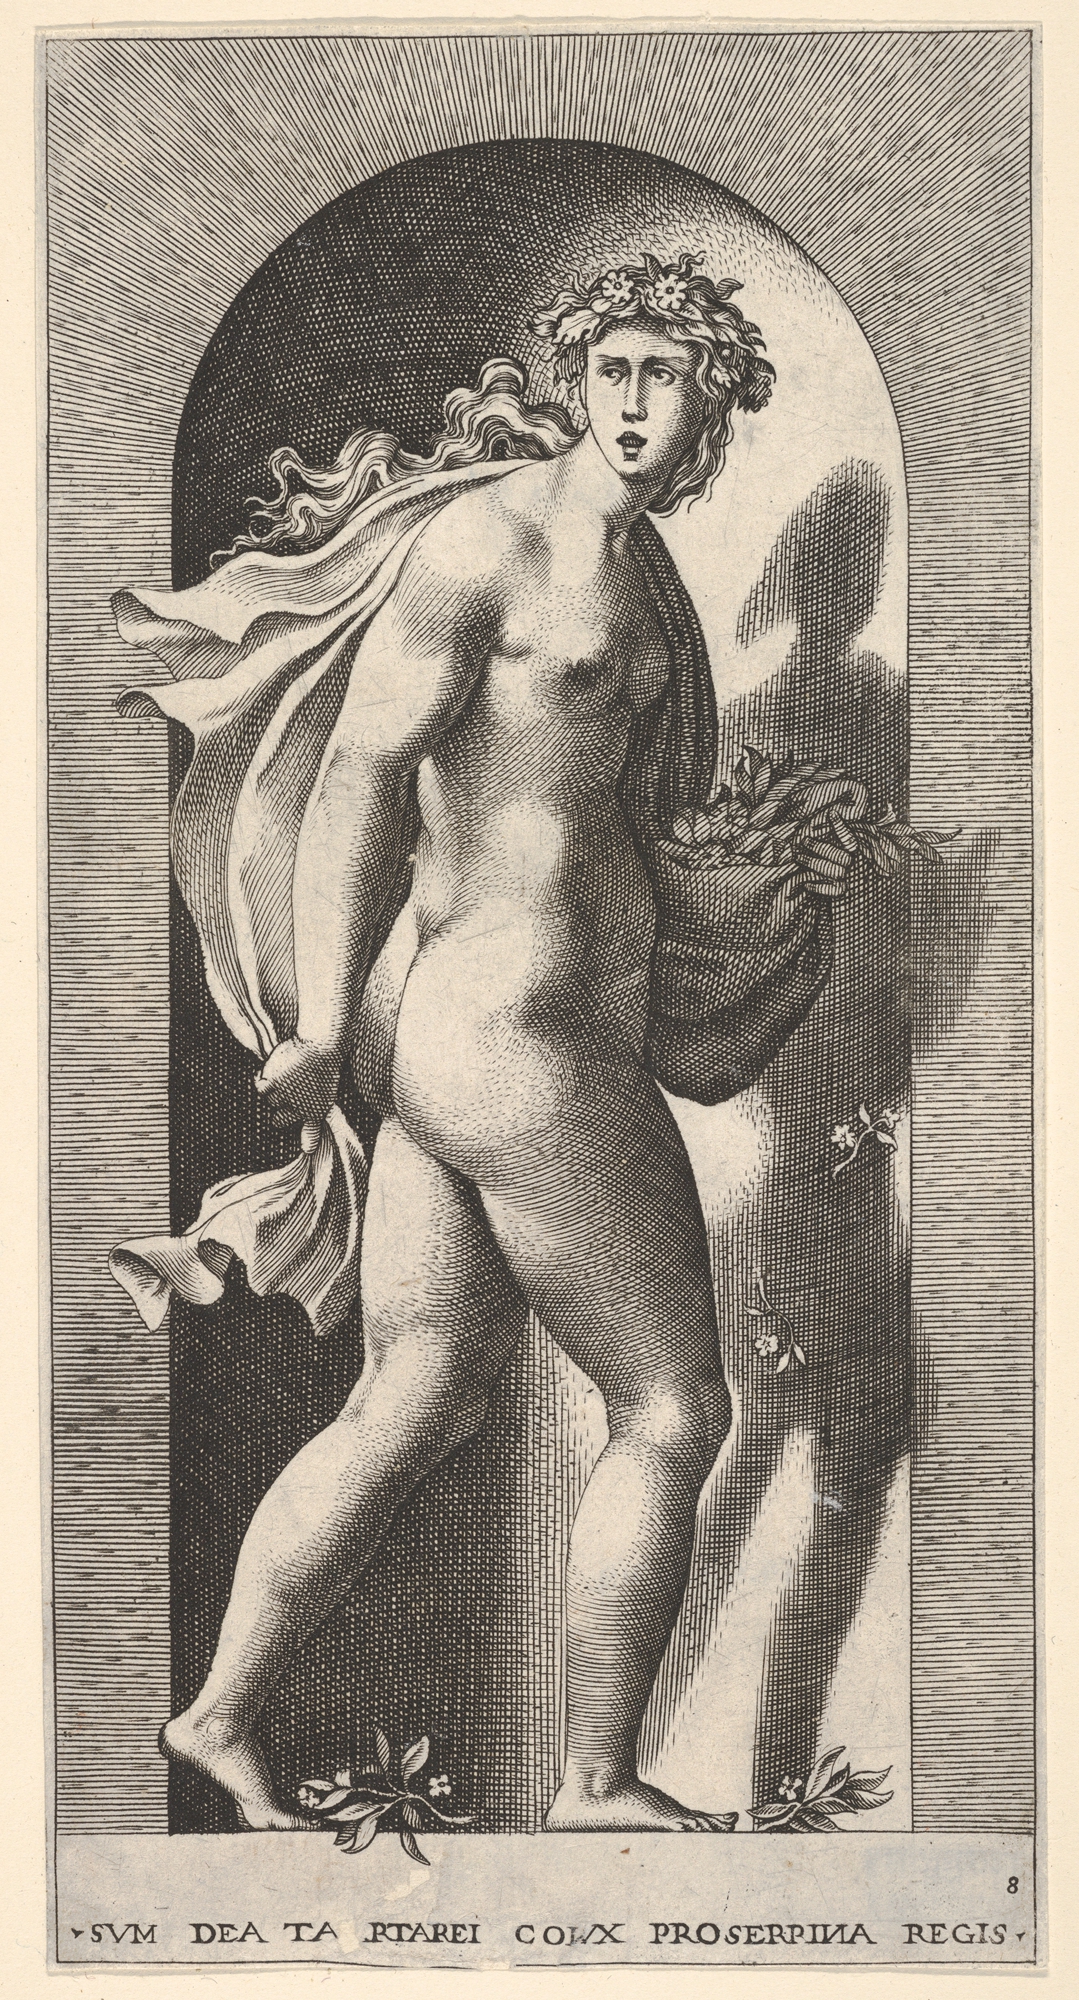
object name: print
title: Plate 8: Proserpina, standing in a niche, turning to the right while holding mantle in both hands and flowers in her right hand, from "Mythological Gods and Goddesses"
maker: giovanni jacopo caraglio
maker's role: artist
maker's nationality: italian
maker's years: 1500-1565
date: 1526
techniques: engraving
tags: goddess